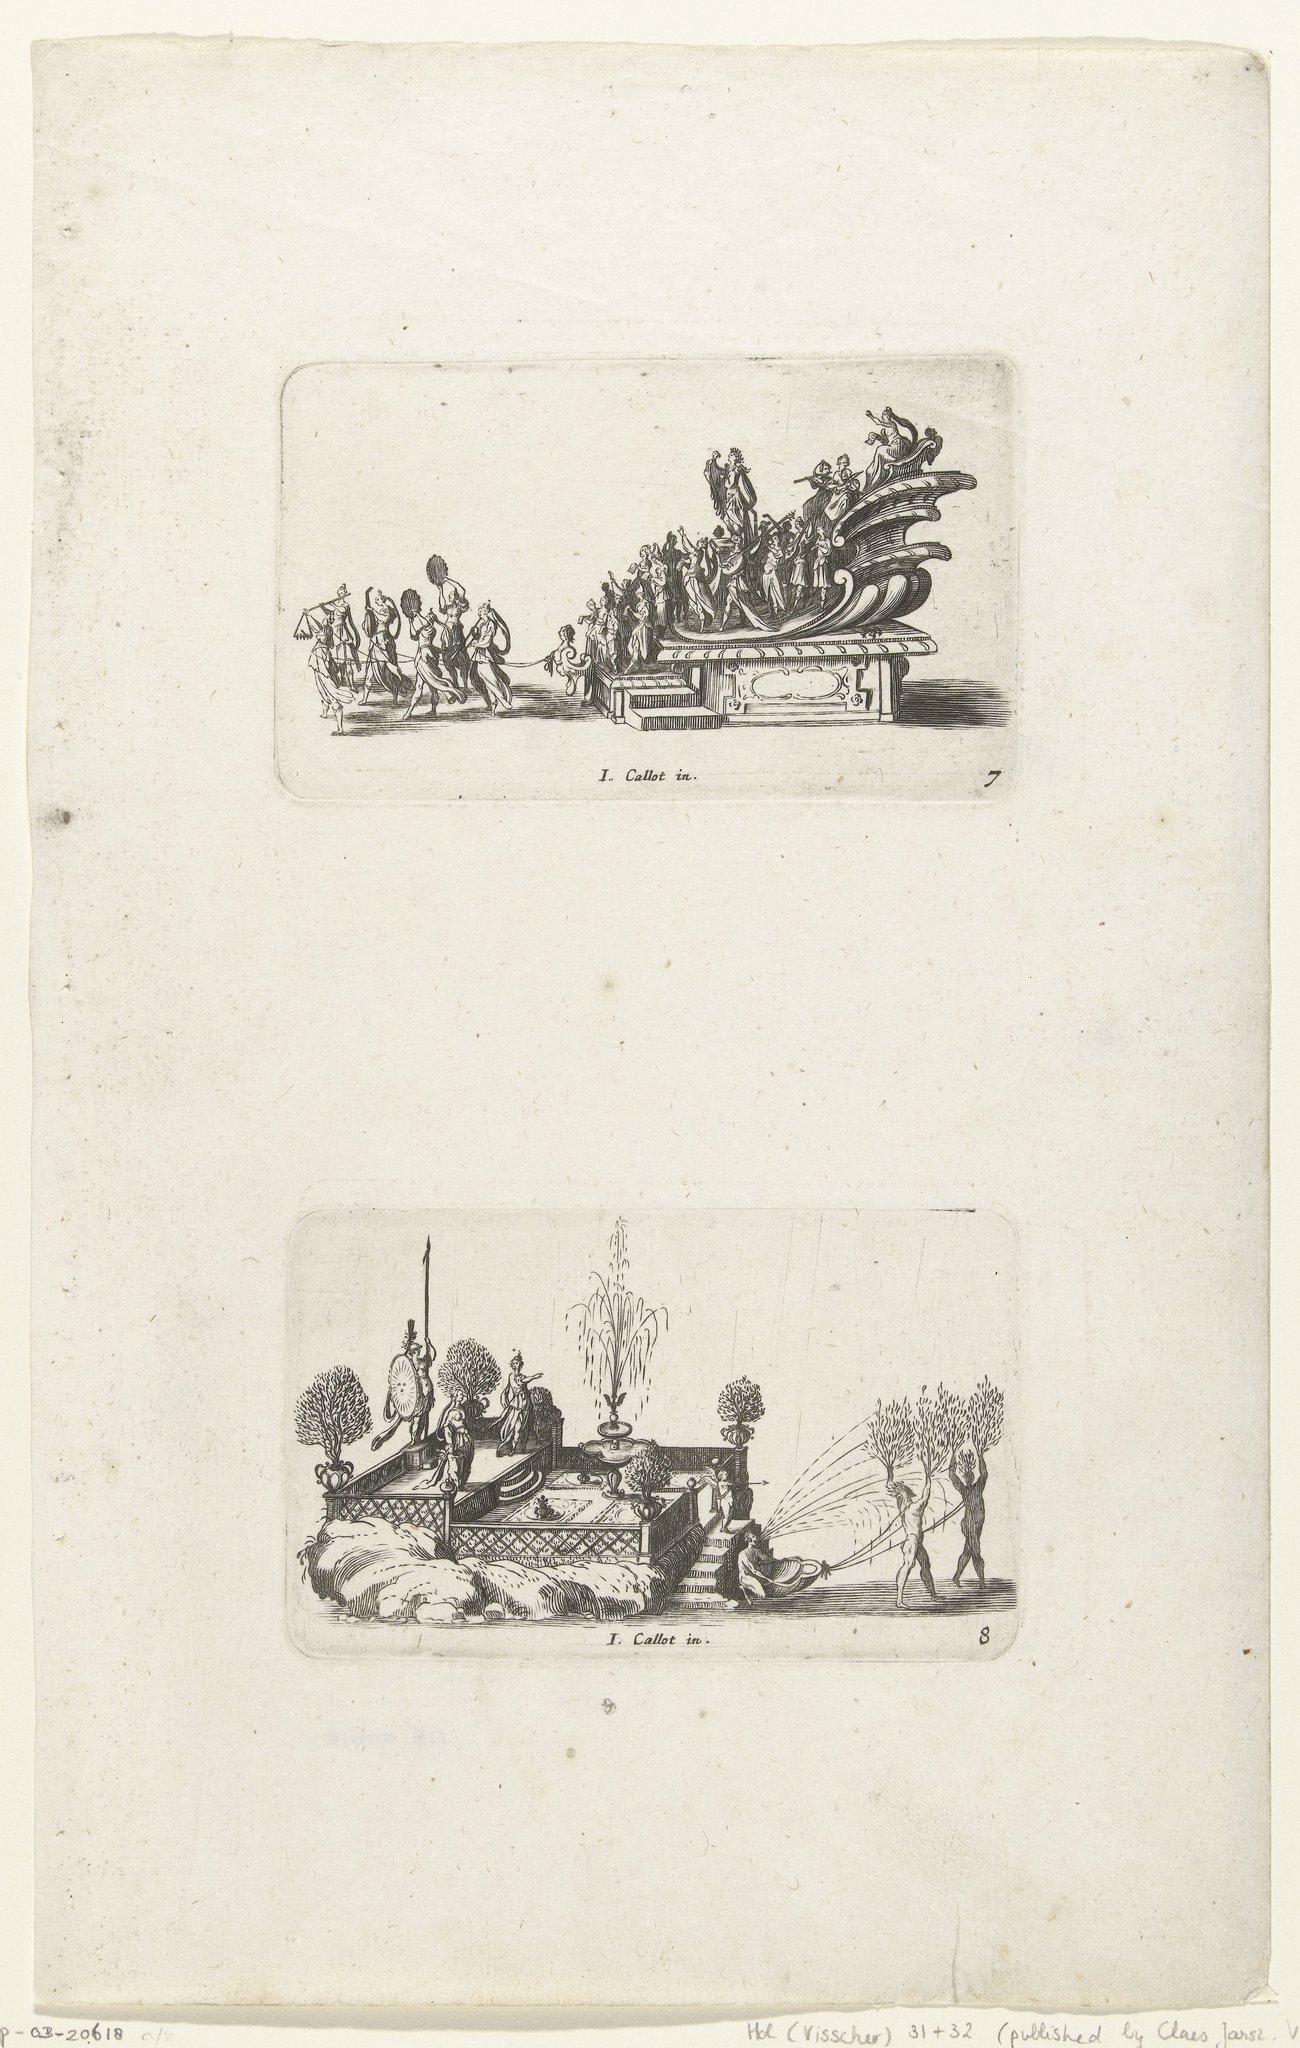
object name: print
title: Triomfwagen van Apollo, Triomfwagen van Juno, Minerva en Venus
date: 1627-1652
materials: paper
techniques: engraving, etching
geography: amsterdam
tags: (story of) juno (hera), (story of) minerva (pallas, athena), garden, chariot, triumphal car, musician(s) accompanying singer(s), apollo playing the lyre, apollo citharoedus, (story of) venus (aphrodite)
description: Bovenste prent: Apollo met een lier en een groep muzikanten en zangers op een podium, voortgetrokken door zes musicerende dames. Onderste prent: een omheinde tuin met Juno, Minerva en Venus, voortgetrokken door twee als bomen verklede mensen. Deze prenten zijn onderdeel van een serie prenten van triomfwagens, kopieën in spiegelbeeld naar details van illustraties uit een boek over de festiviteiten (o.a. een toernooi) in het hertogelijk paleis te Nancy op 14 februari 1627.